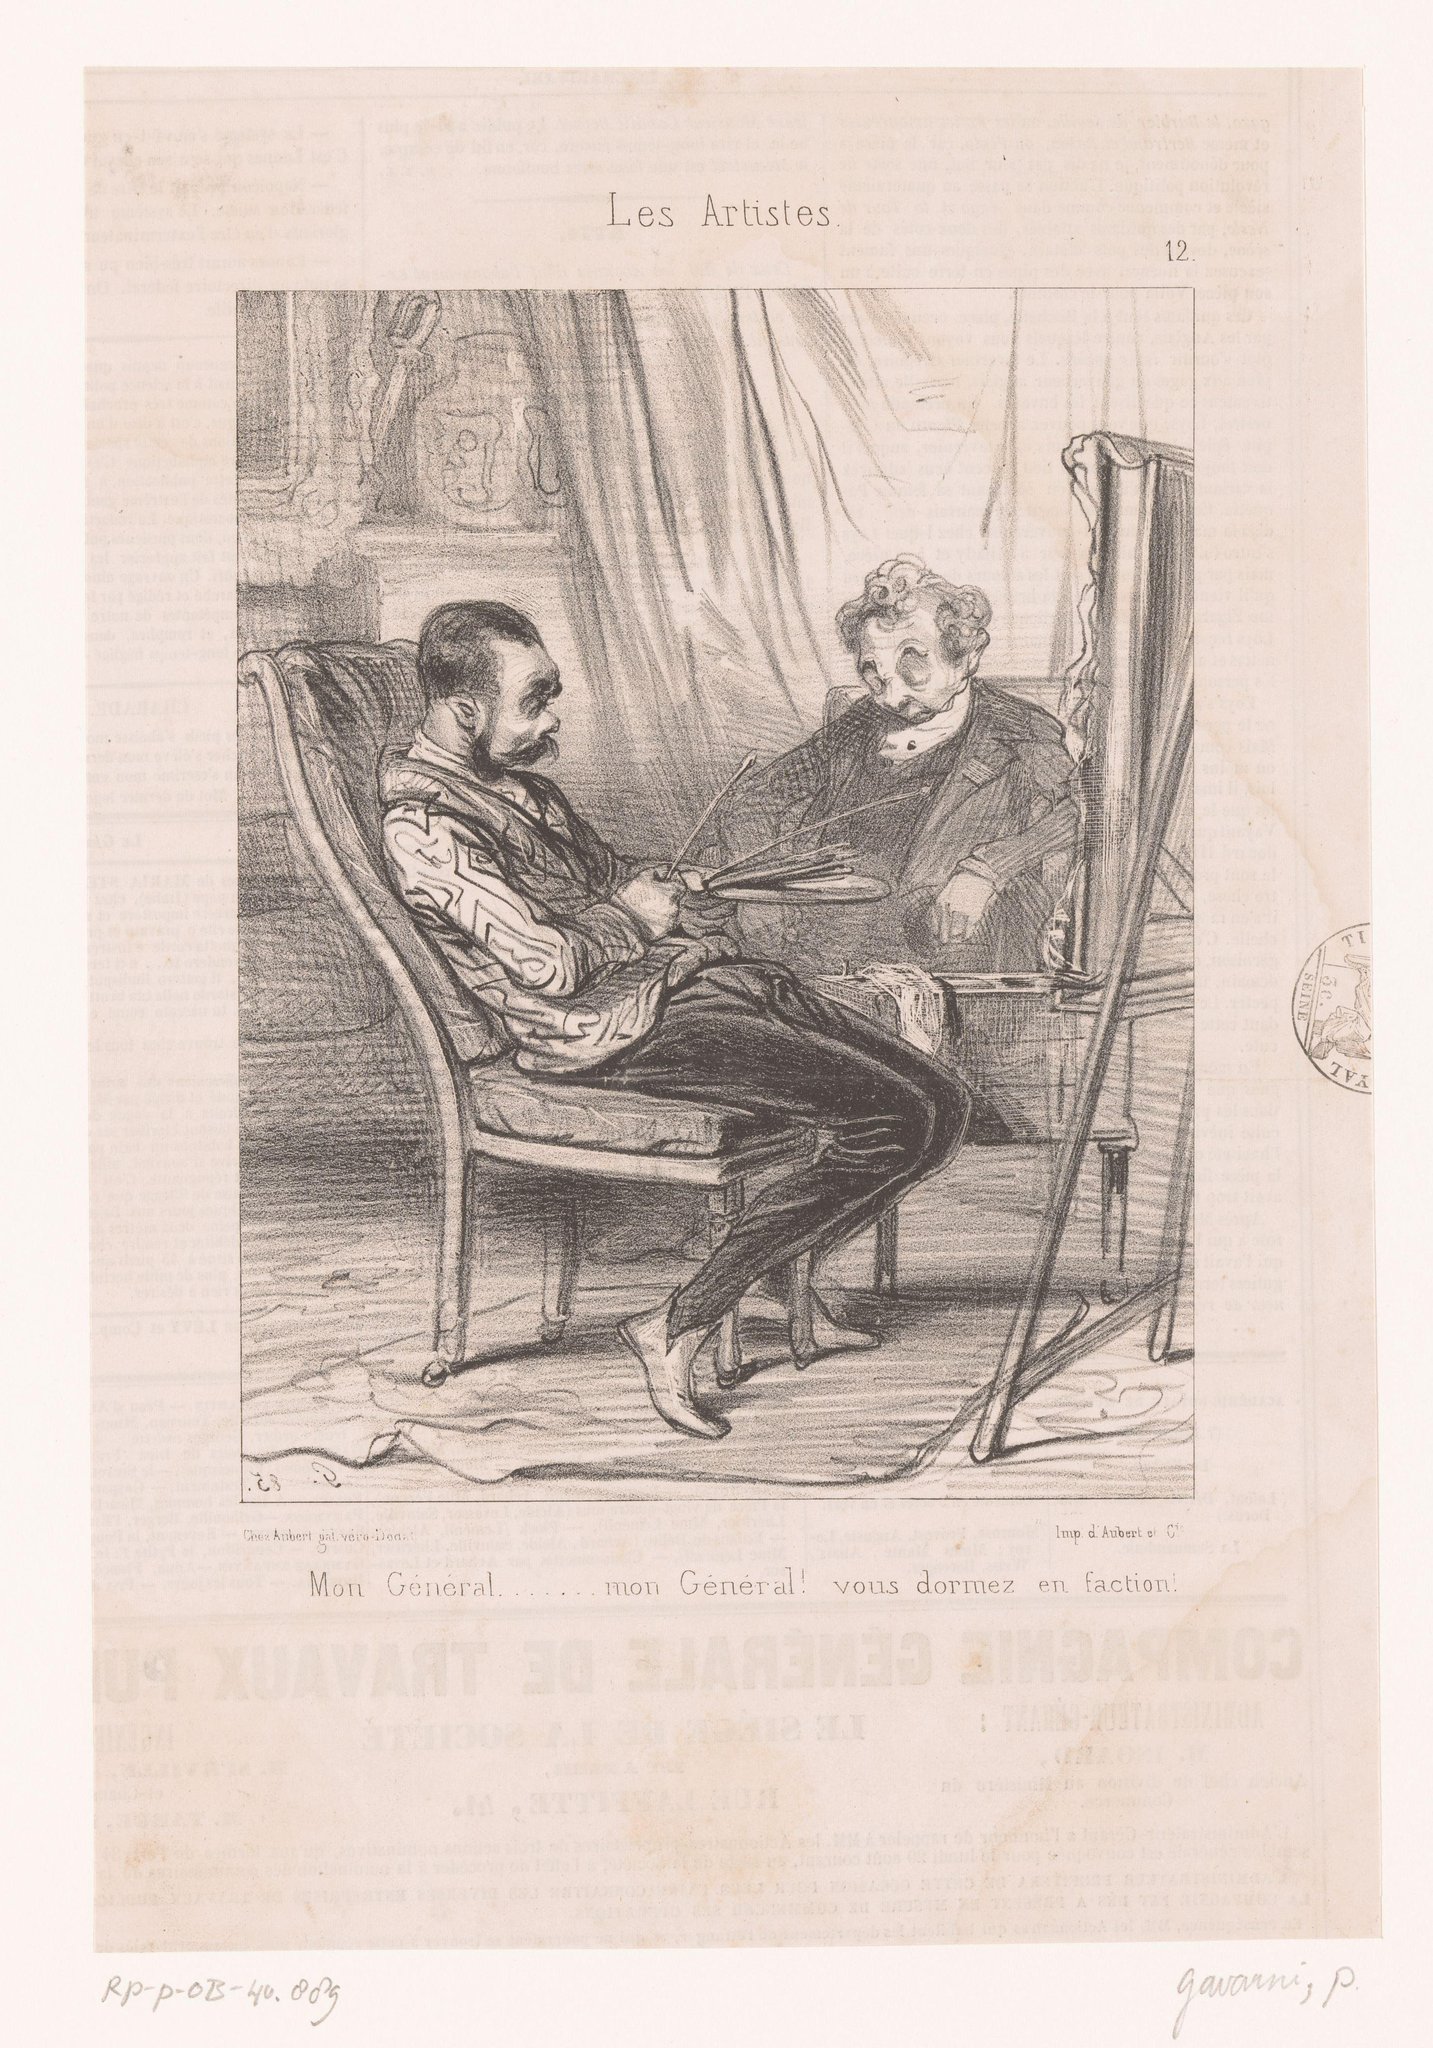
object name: print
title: Schilder wekt zijn in slaap gevallen model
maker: paul gavarni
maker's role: draughtsman, print maker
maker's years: 1804-1866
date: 1838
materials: paper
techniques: lithograph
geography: paris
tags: artist's model, sitter, painter working from live model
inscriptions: collector's mark: Lugt 2228a, stamp: ‘Timbre Royal / 3c. / Seine’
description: Prent gebruikt voor: Le Charivari, 15 augustus 1838.